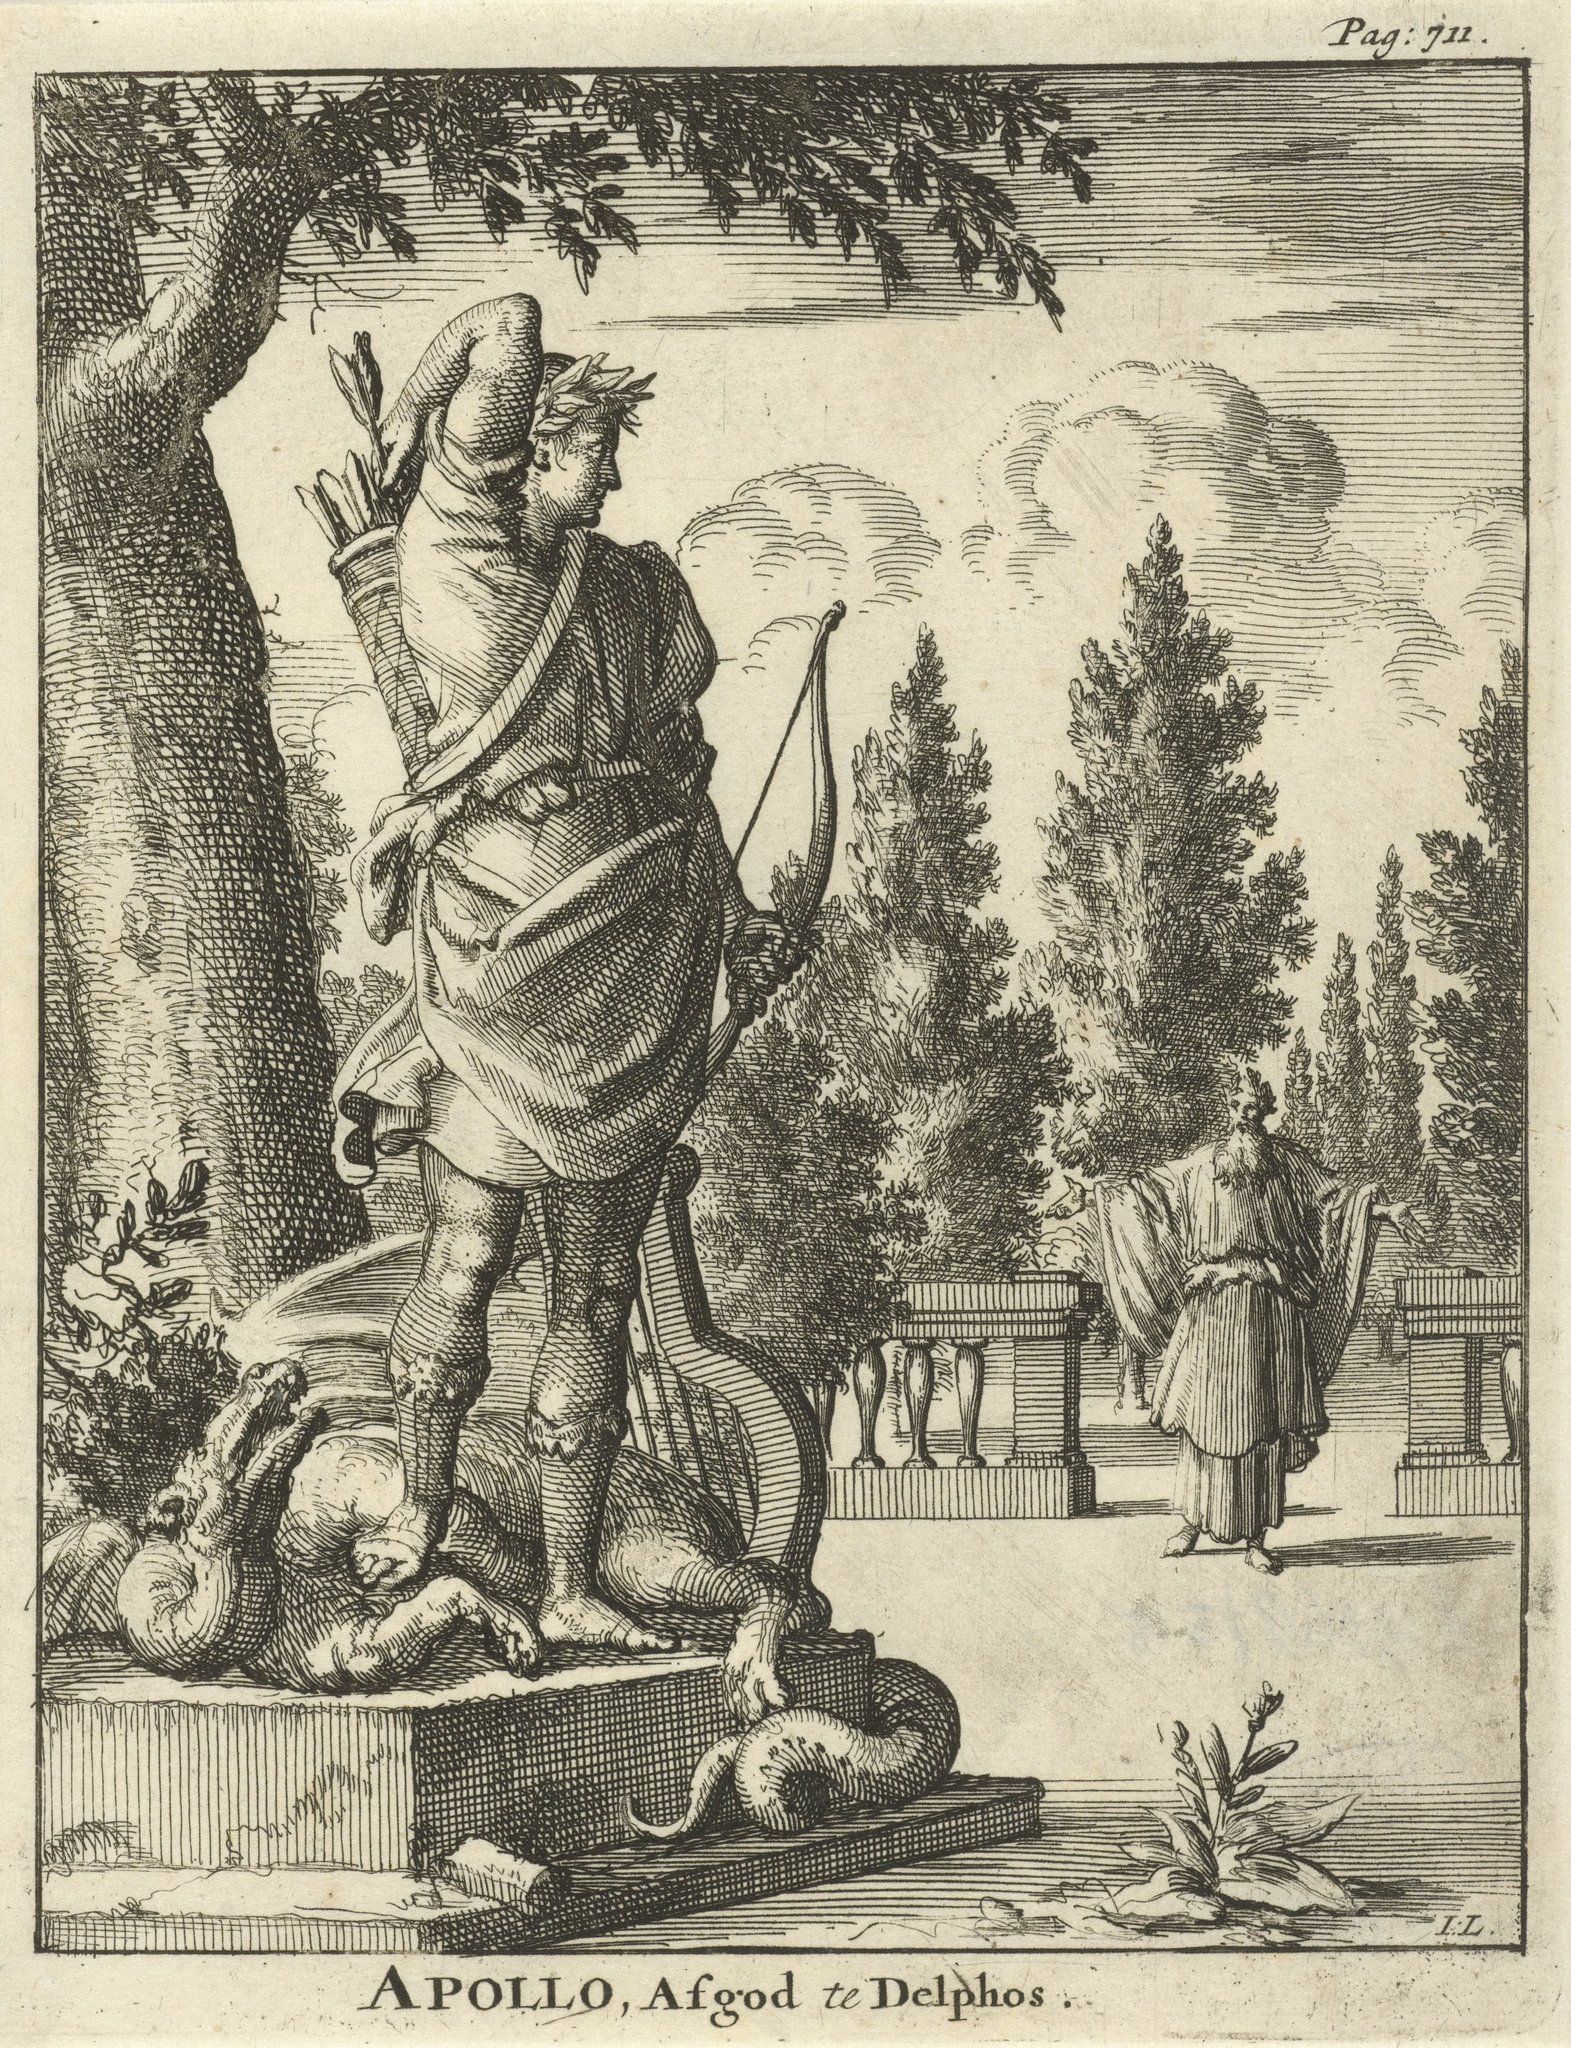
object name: book illustration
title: Apollo, Afgod te Delphos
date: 1686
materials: paper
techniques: etching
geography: amsterdam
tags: apollo shoots python, the dragon, (story of) apollo (phoebus), statues, paintings, etc. ~ objects of worship in roman religion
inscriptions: collector's mark: Lugt 2228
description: Illustratie uit: Aysma, Joannes. Het ryck der goden, onder den eenige waare God, 2 delen. Amsterdam: Timotheus ten Hoorn, 1686, dl. II, p. 711.